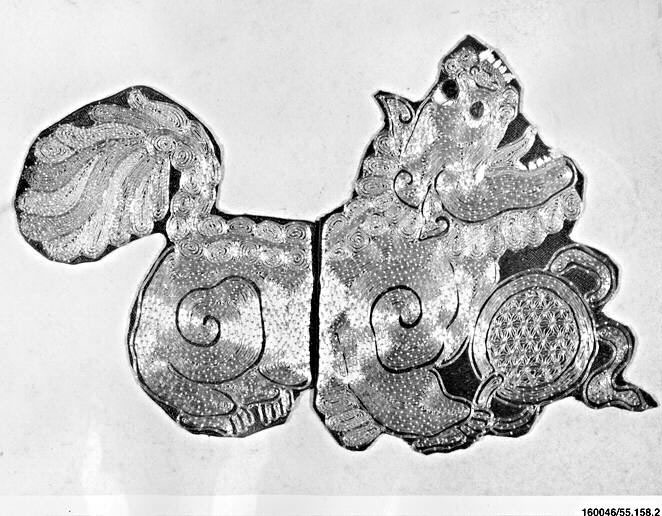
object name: appliqué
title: Applique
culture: chinese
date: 1867-1933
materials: metal thread, silk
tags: lions